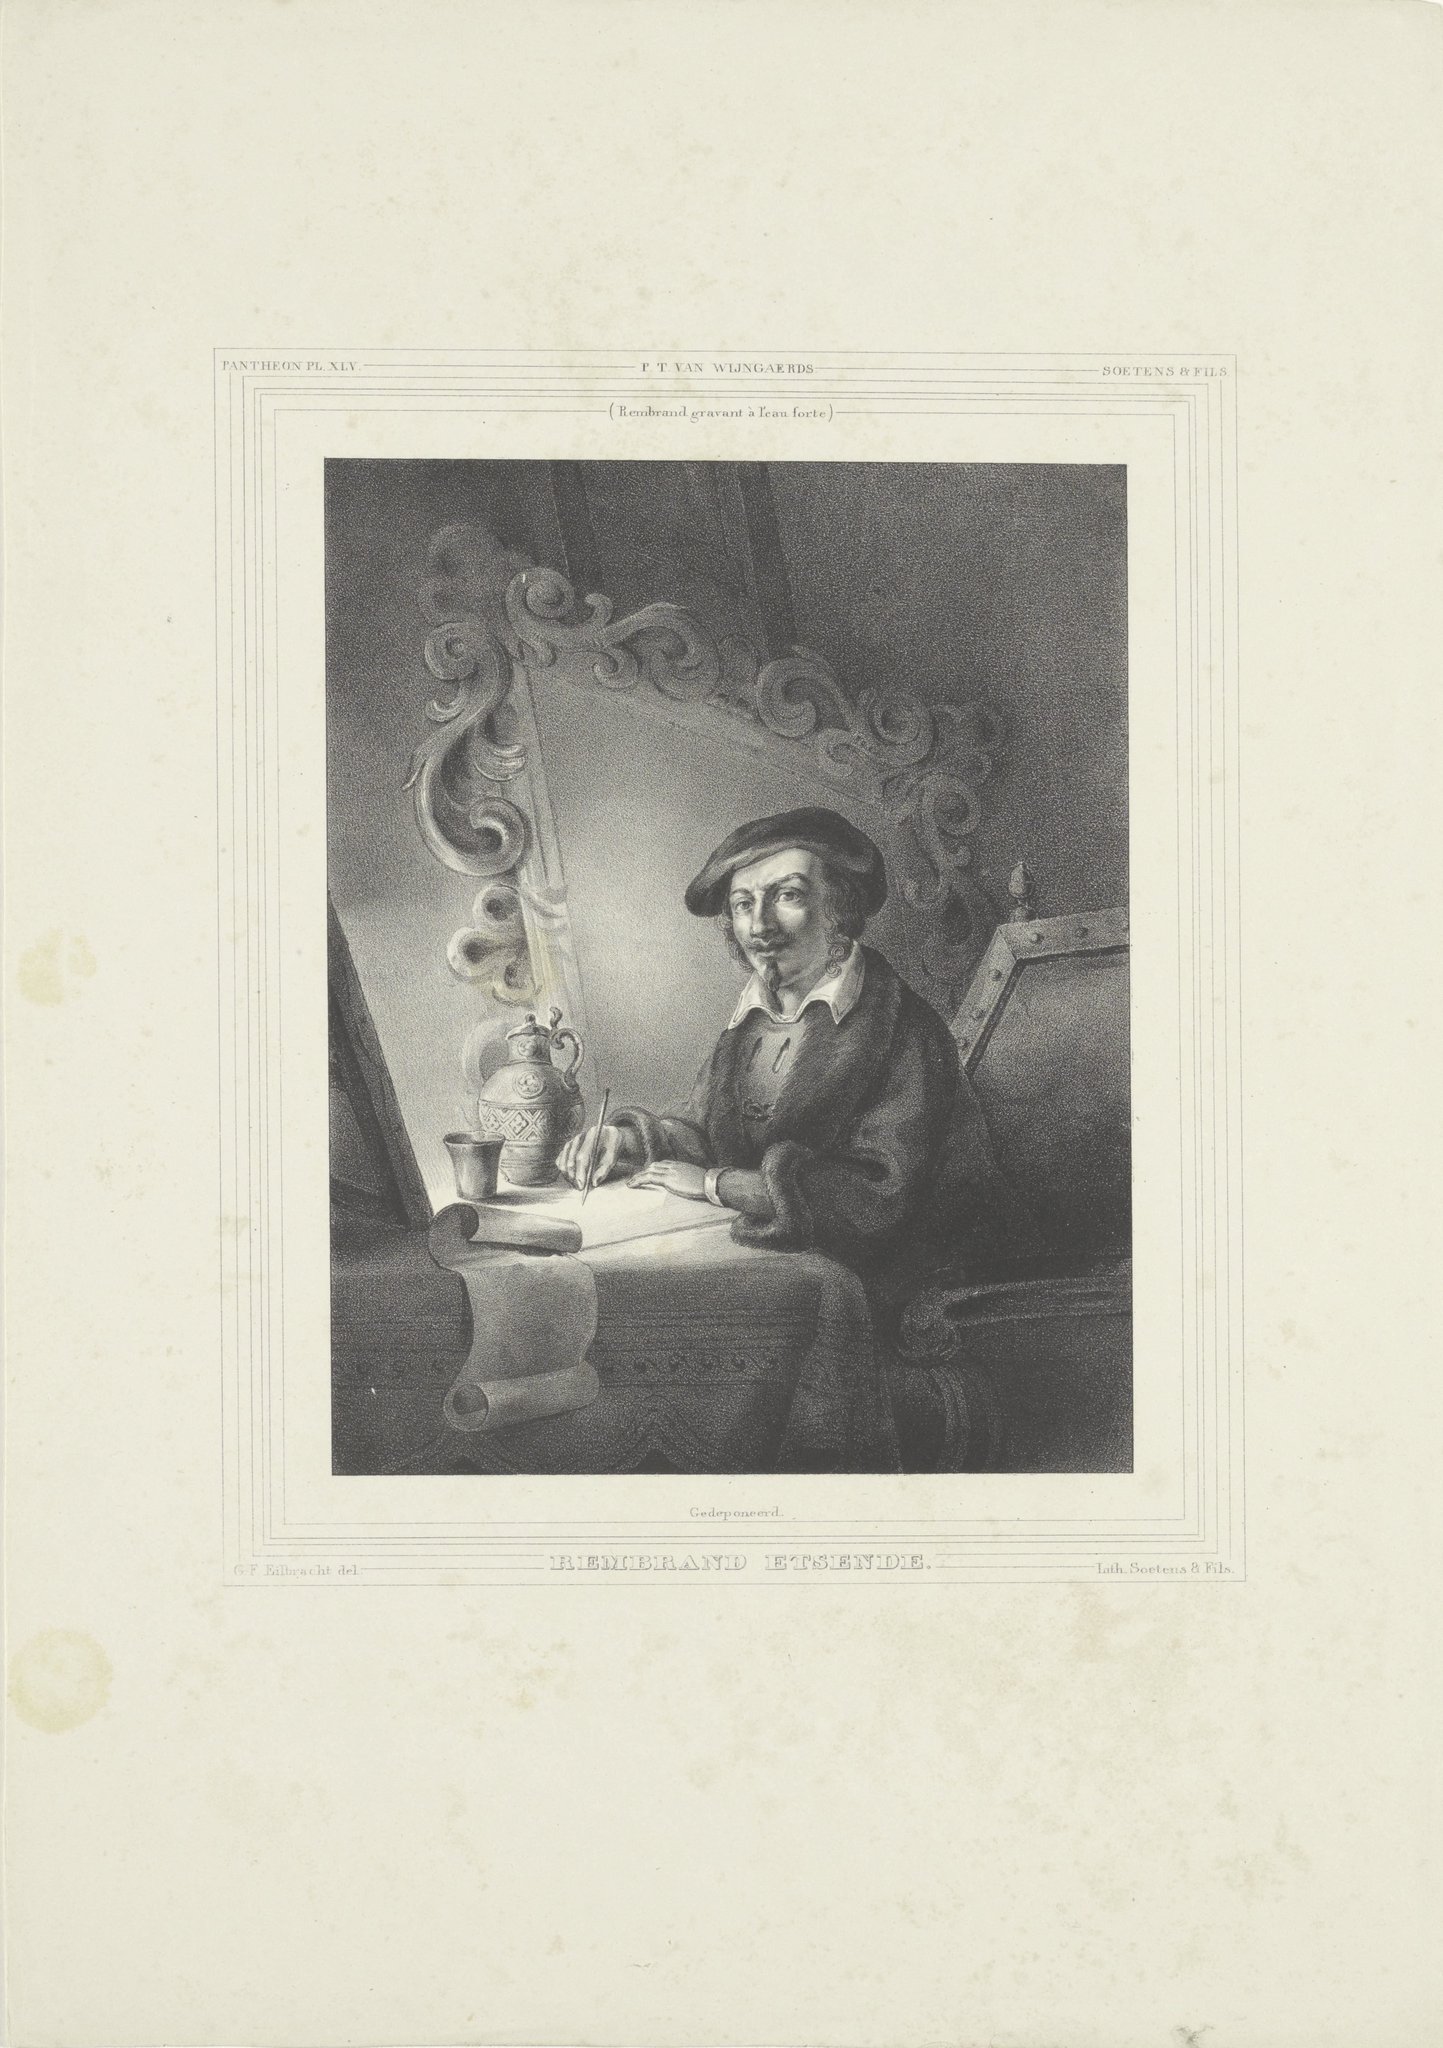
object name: print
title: Rembrand etsende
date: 1837-1840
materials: paper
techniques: lithograph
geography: the hague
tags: leiden, amsterdam, painter, print maker, draughtsman, rembrandt van rijn, etching, artist at work, in his workshop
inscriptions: collector's mark: Lugt 2228, : ‘Gedeponeerd.’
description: Rembrandt zit aan tafel. Achter hem staat een groot ingelijst schilderij op een ezel. Voor hem op tafel staat een ander schilderij dat hij na tekent op een etsplaat. Op de tafel een karaf, een beker en een vel papier. De schilder draagt een baret en een mantel gevoerd met bont.